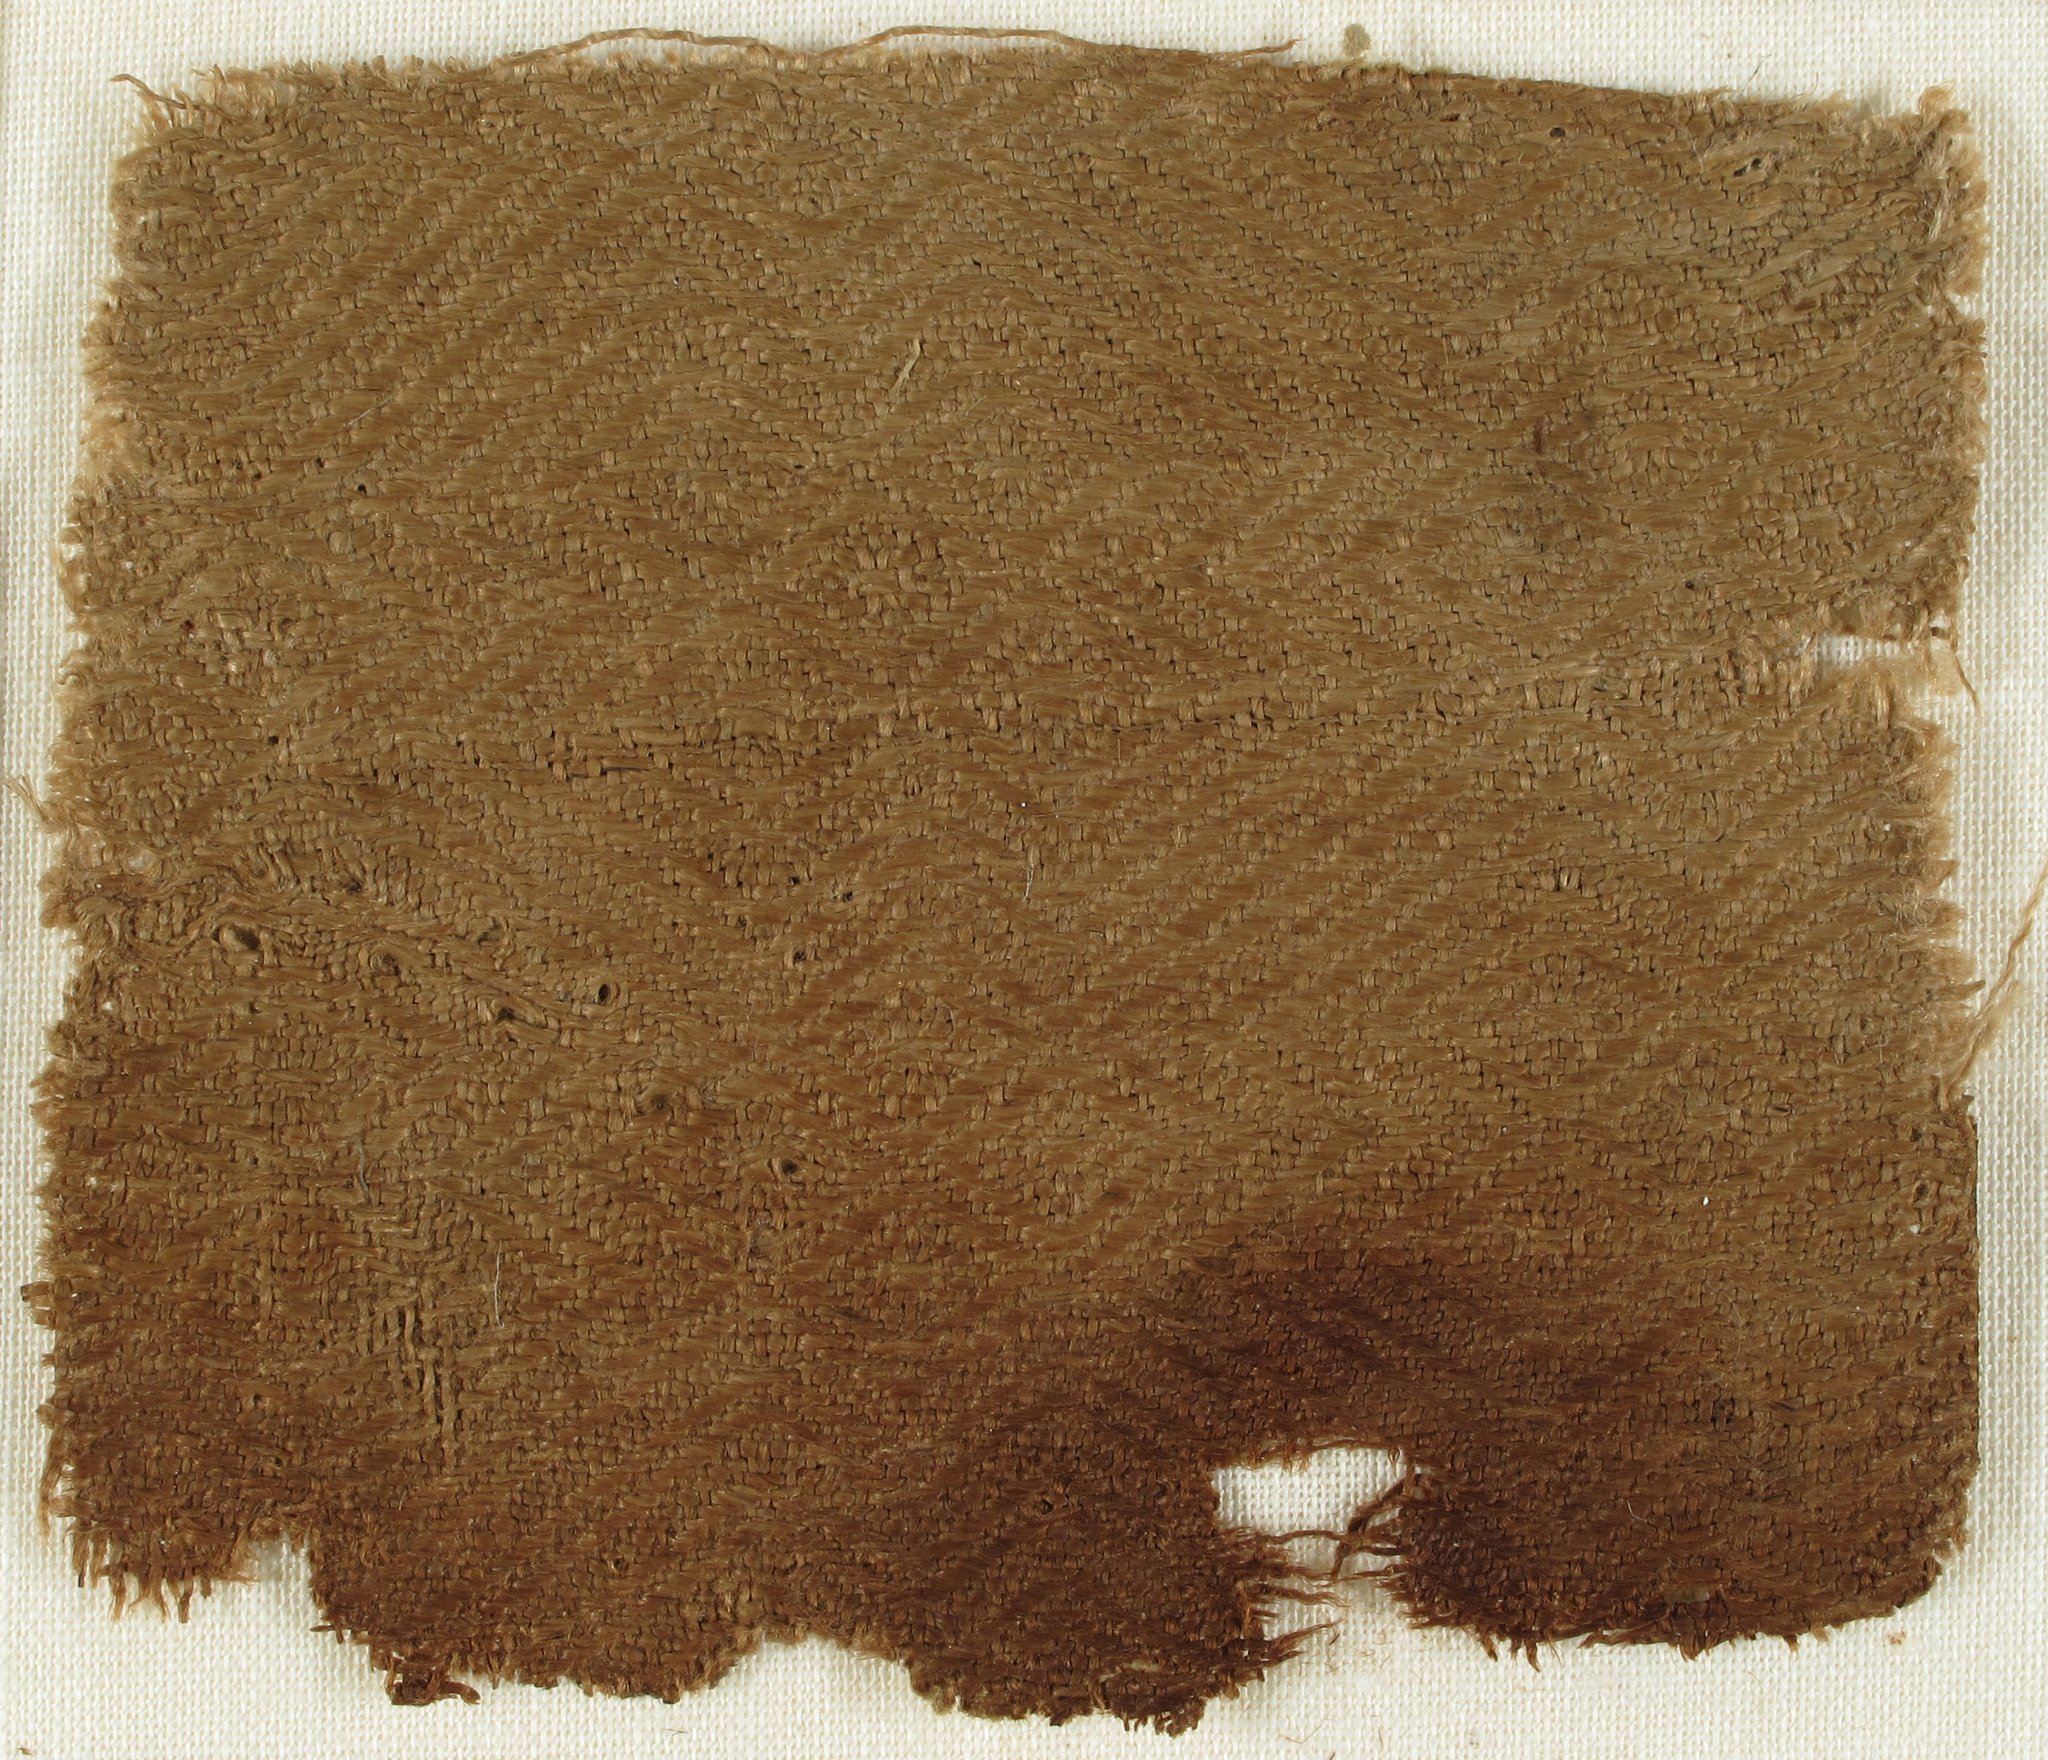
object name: textile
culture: german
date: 1401-1500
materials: linen